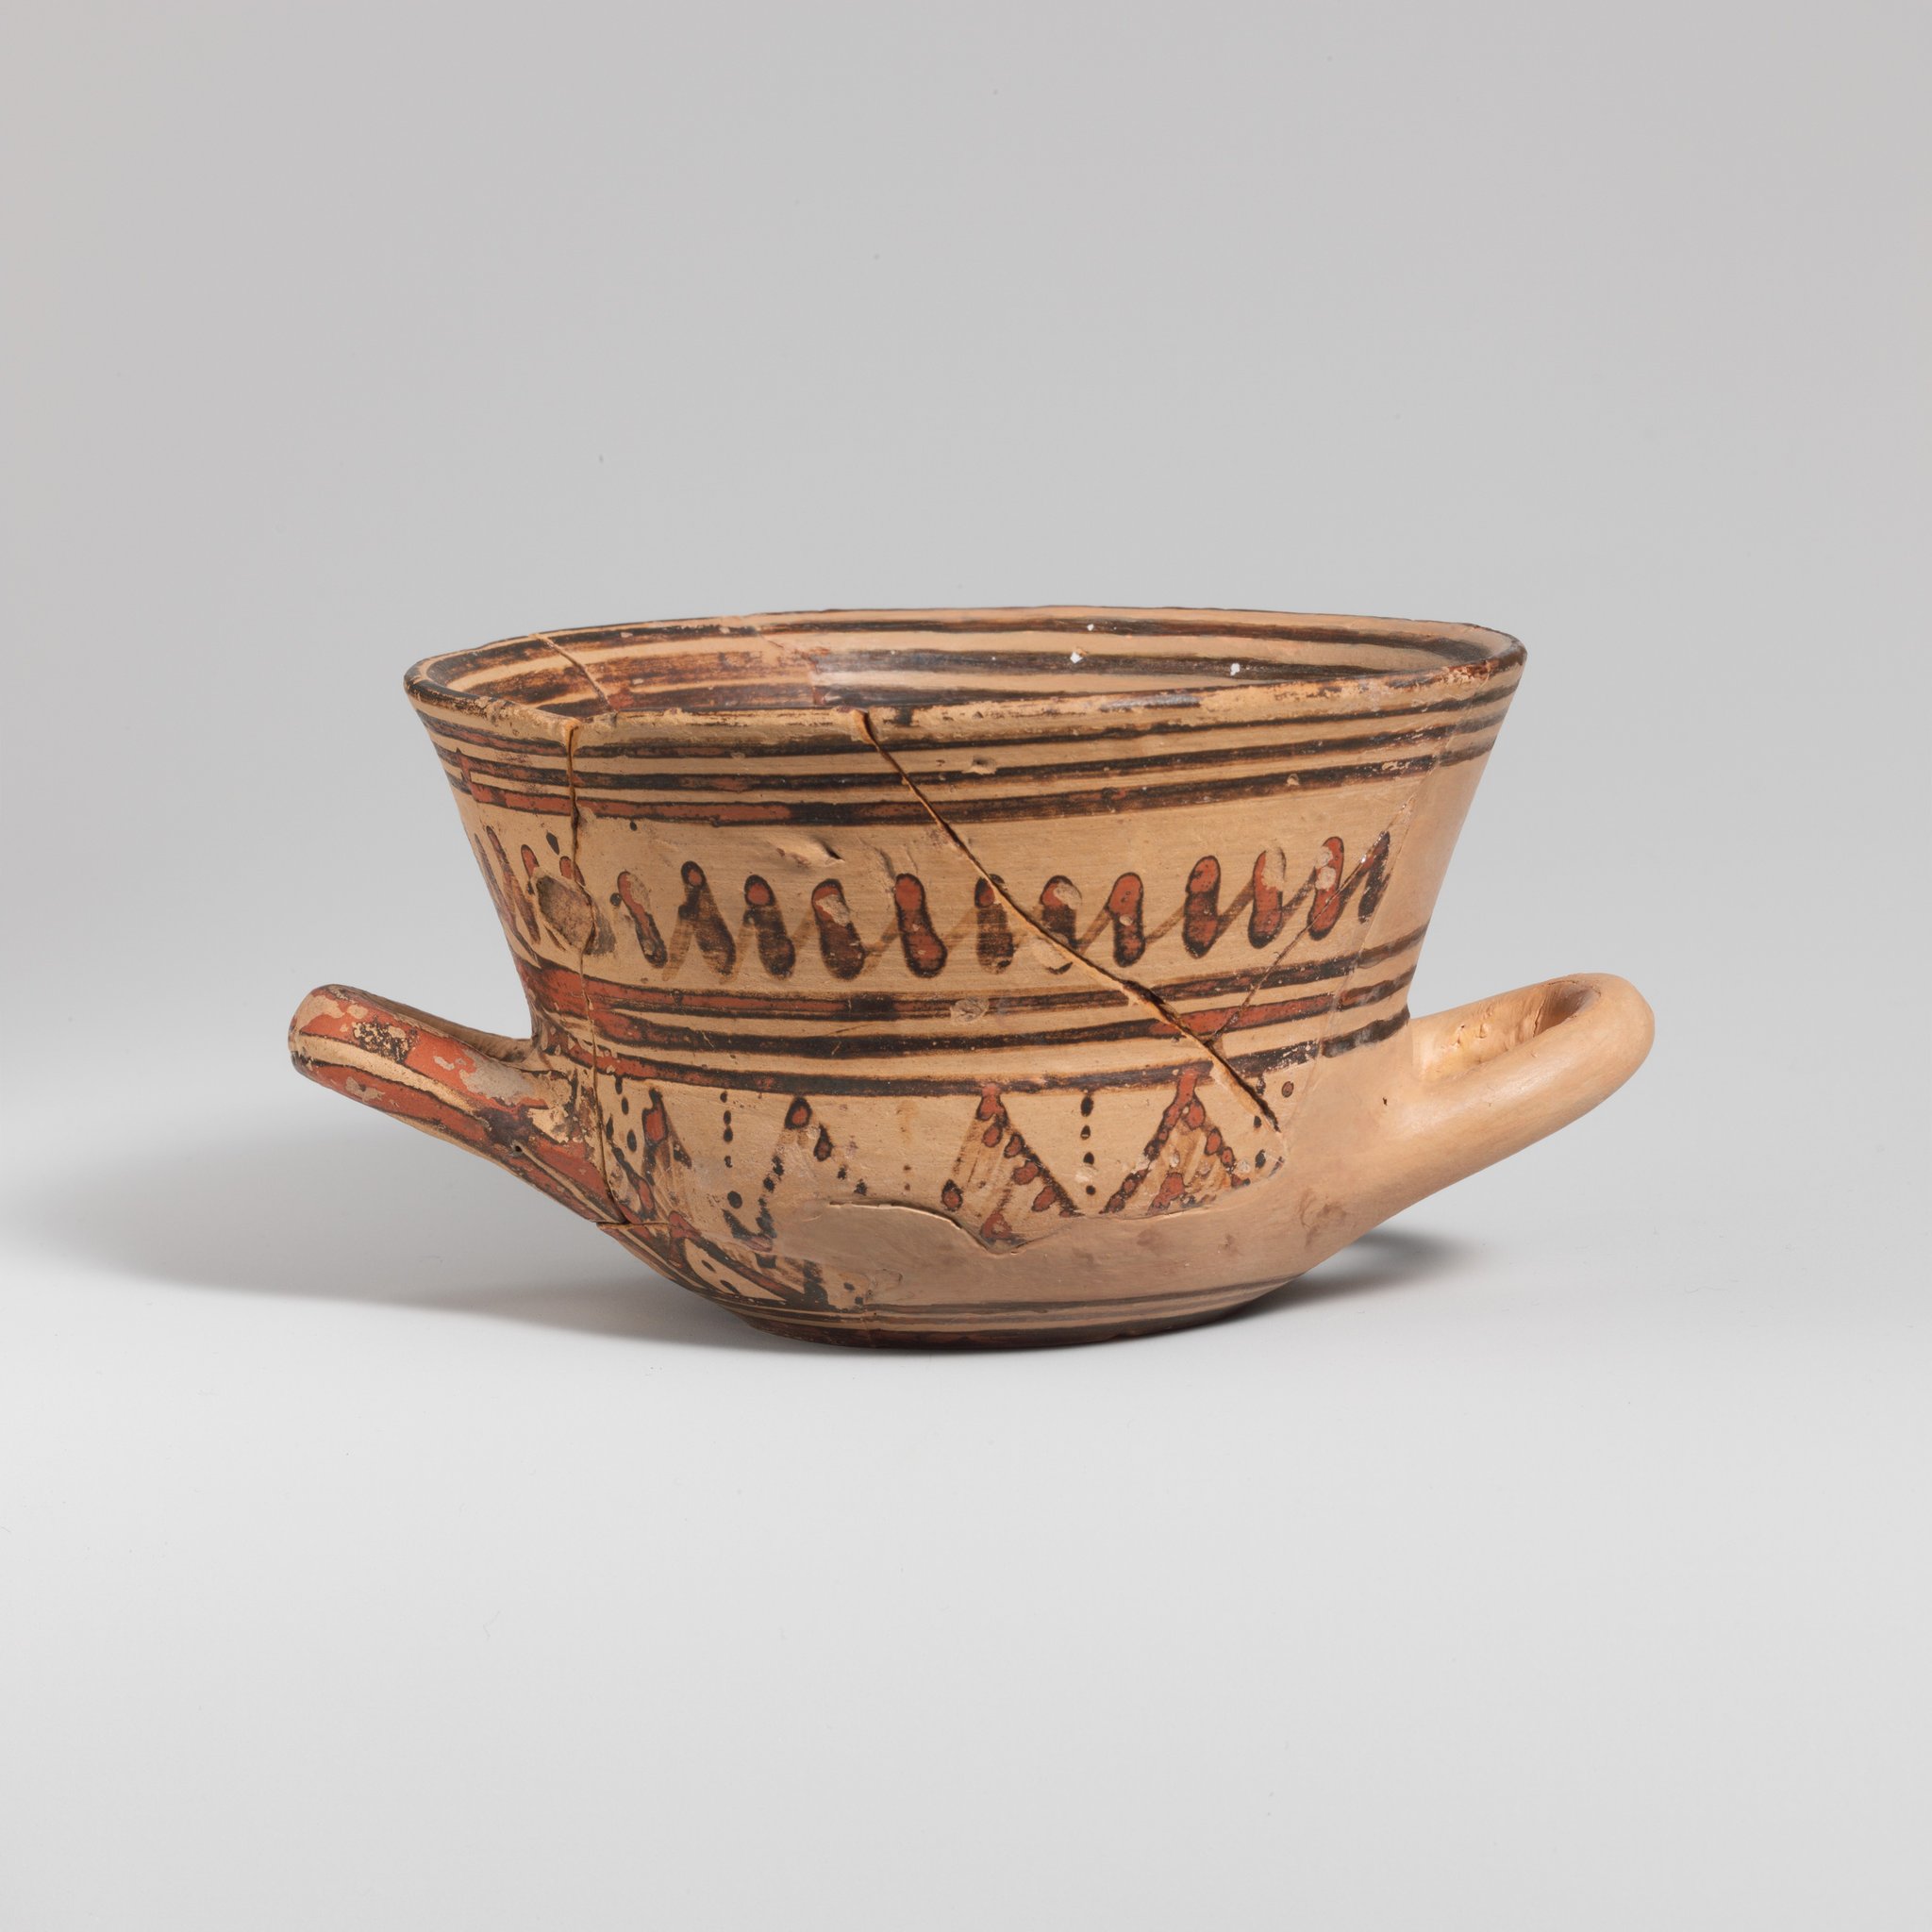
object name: skyphos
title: Terracotta skyphos (deep drinking cup)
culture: greek, attic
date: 734-701 BCE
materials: terracotta